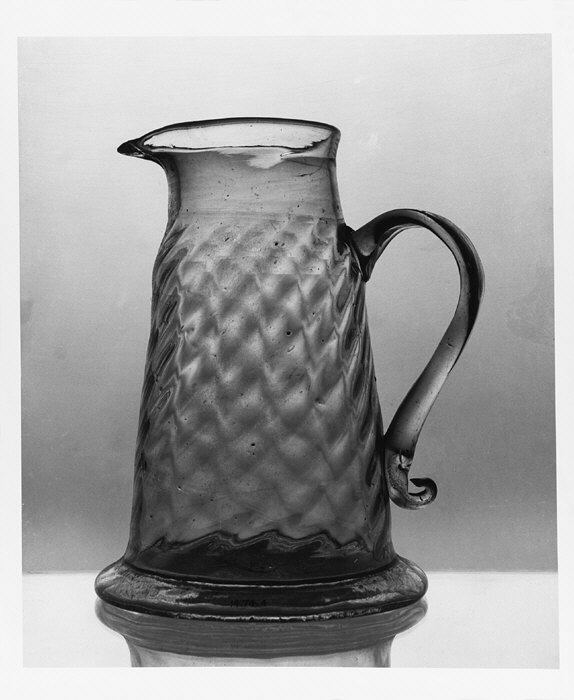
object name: molasses jug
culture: american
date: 1800-1830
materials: gemstone, glass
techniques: glassblowing, molding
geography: united states